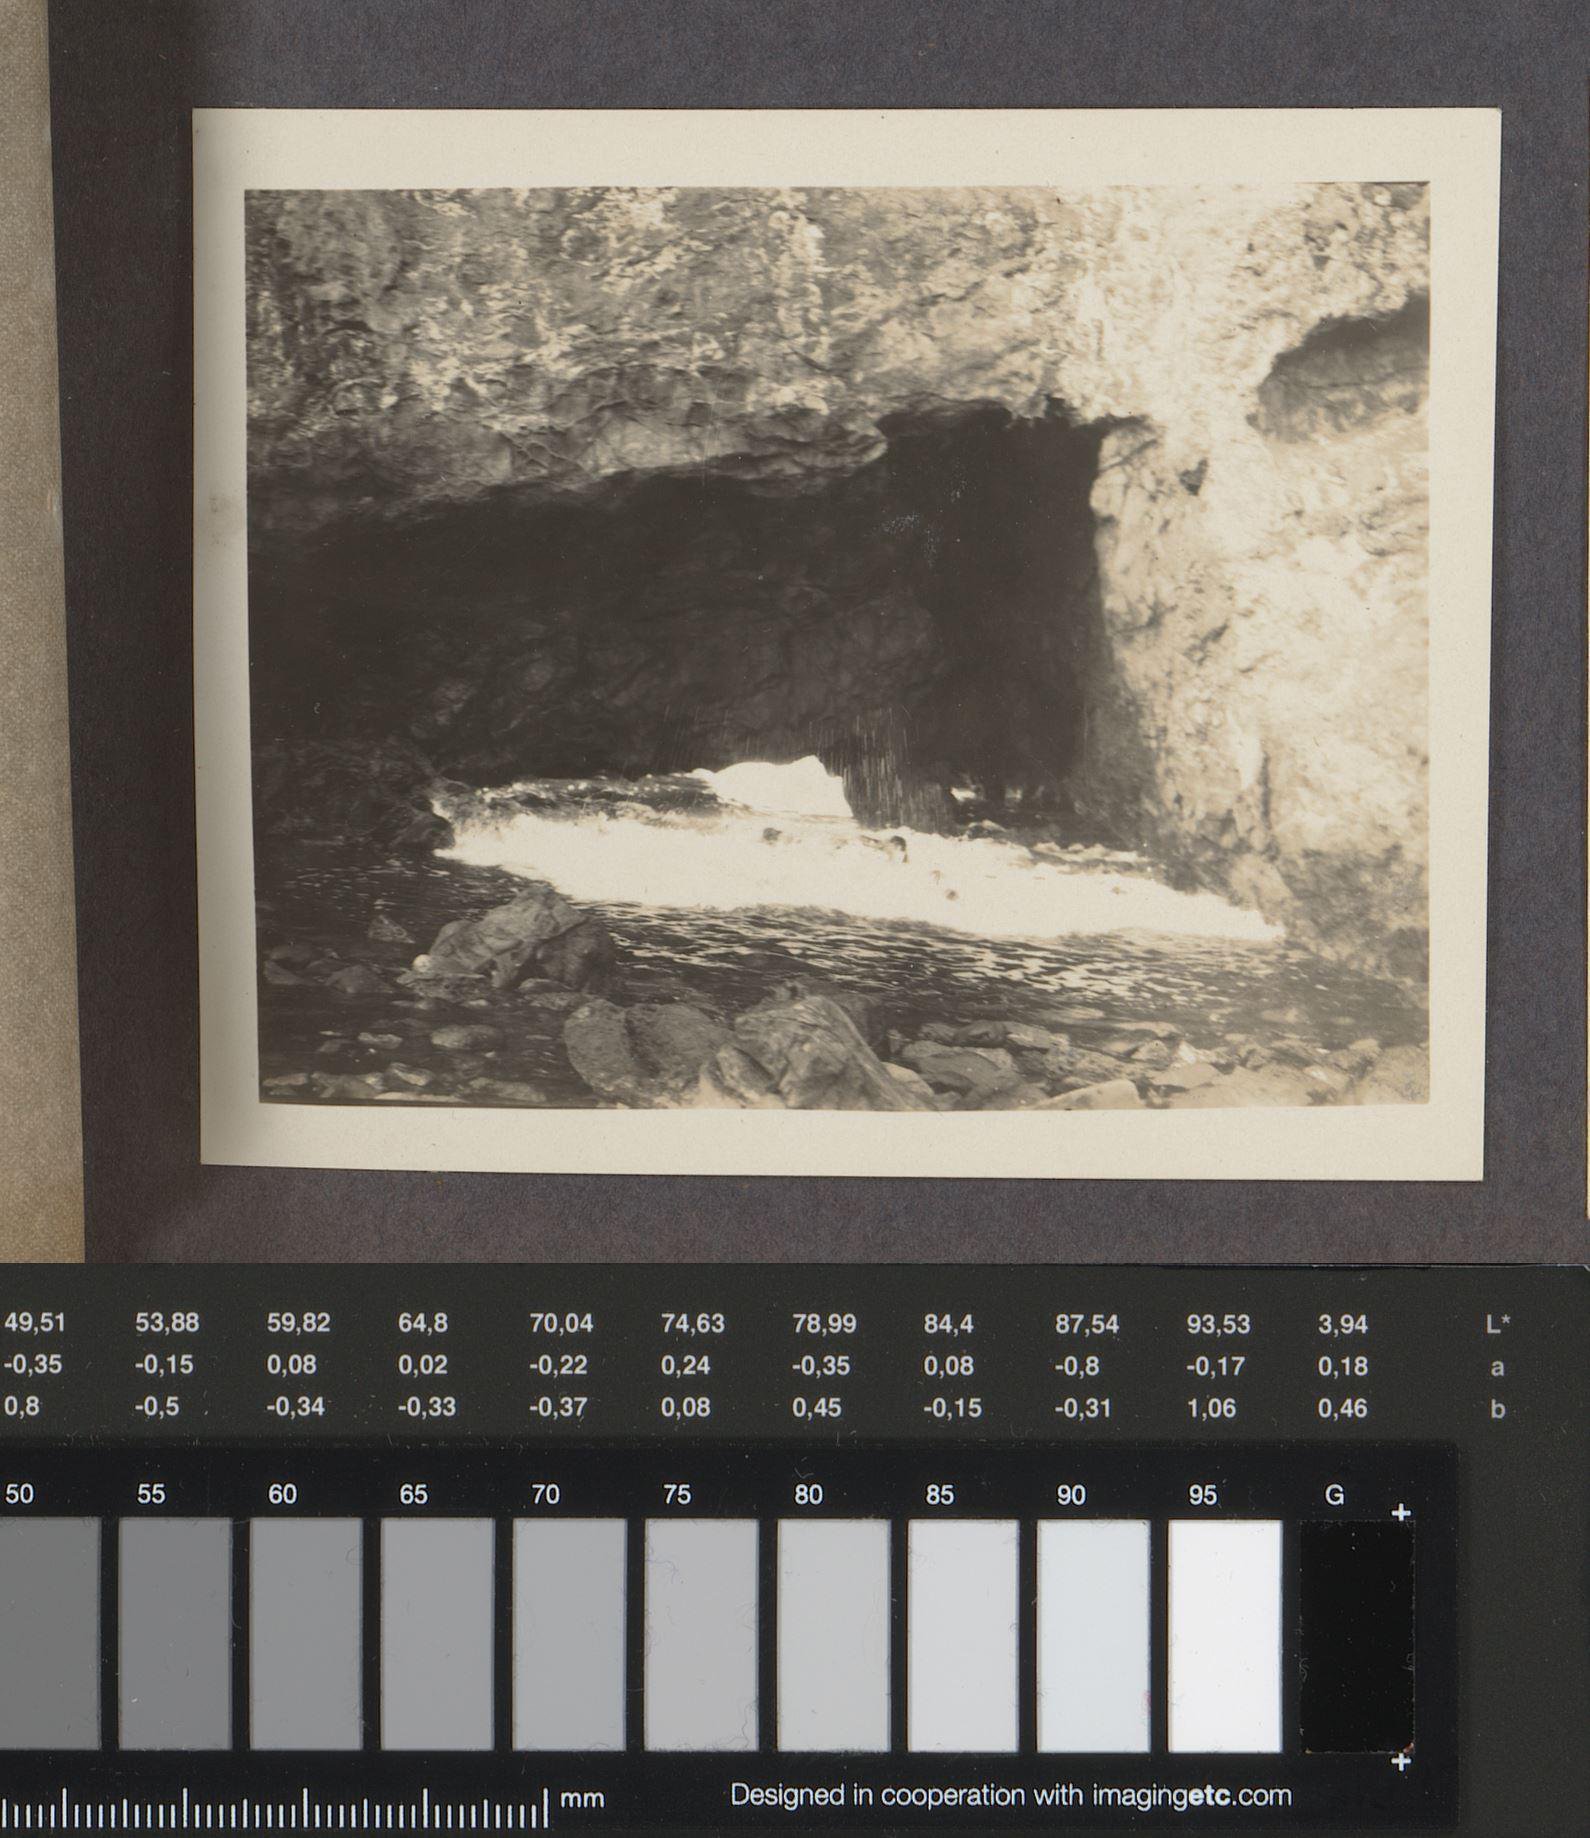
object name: photograph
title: Rodeo bij Baker Ranch in de omgeving van Saugus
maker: Anonymous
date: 1928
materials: photographic support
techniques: gelatin silver print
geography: saugus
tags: historical persons, the audience ~ art performance, rodeo, horse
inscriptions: annotation: ‘Baker Ranch "Rodeo" bij Saugus/ Kampioenwedstrijd cowboys ééns per jaar’